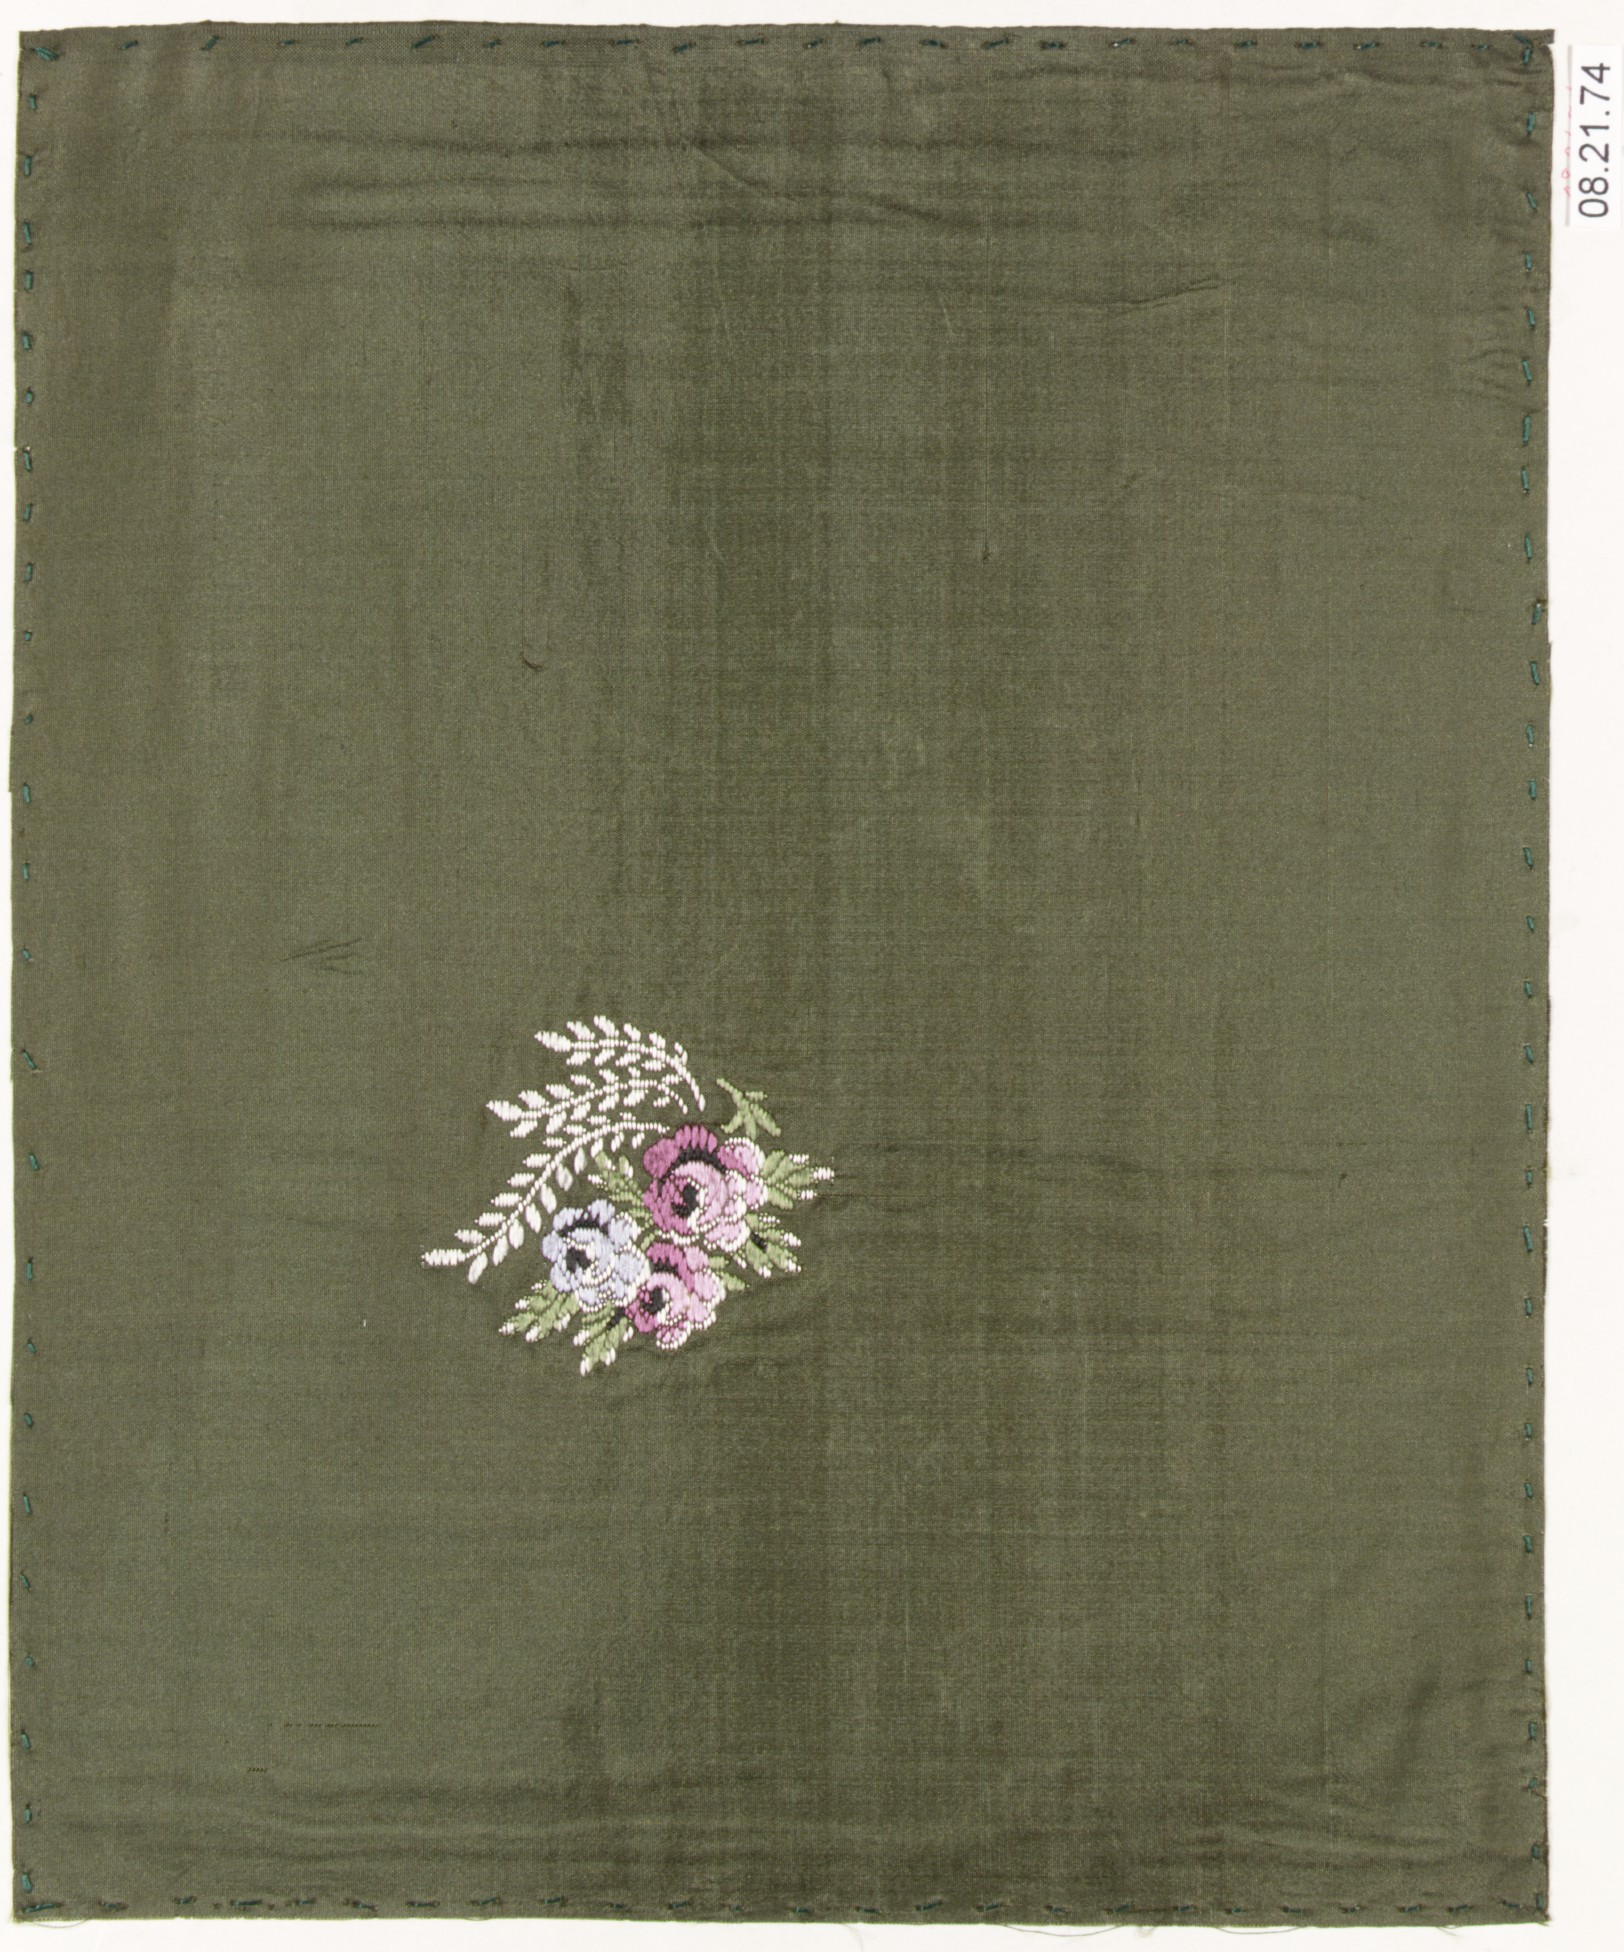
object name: textile sample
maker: Anonymous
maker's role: designer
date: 1900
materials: silk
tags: flowers